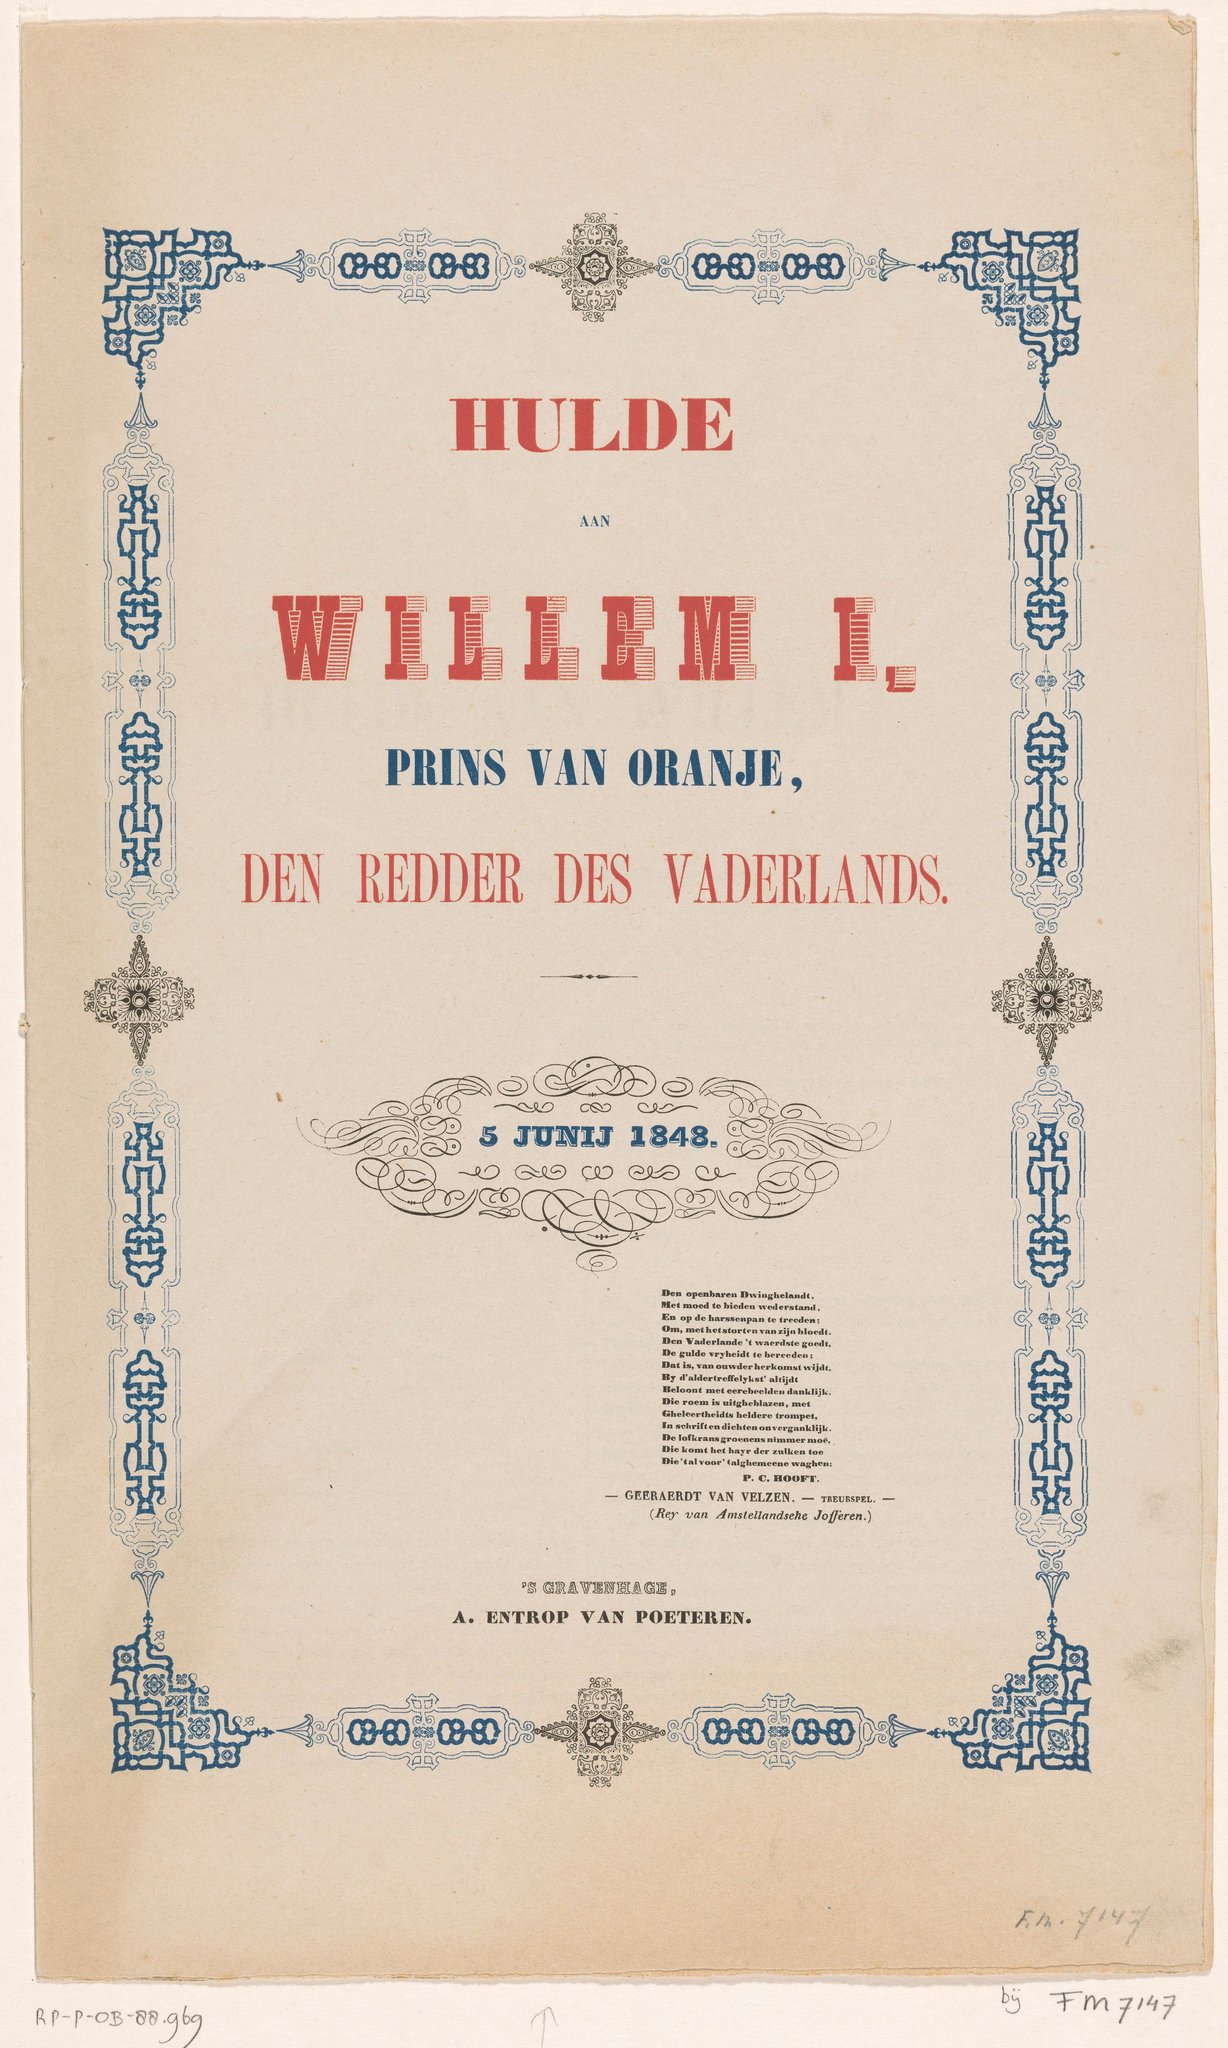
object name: text sheet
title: Hulde aan Willem I, prins van Oranje, den redder des vaderlands. 5 Junij 1848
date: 1805-1848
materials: paper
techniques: letterpress printing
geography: the hague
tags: delft, william i (prince of orange)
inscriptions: collector's mark: Lugt 2228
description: Teksten ter ere van de prins bij de onthulling van het standbeeld van prins Willem van Oranje op het Plein te Den Haag, op 5 juni 1848. Twee dubbelgevouwen bladen bedrukt met tekst. Op de voorzijde de titel binnen een decoratieve omlijsting in rood en blauw.